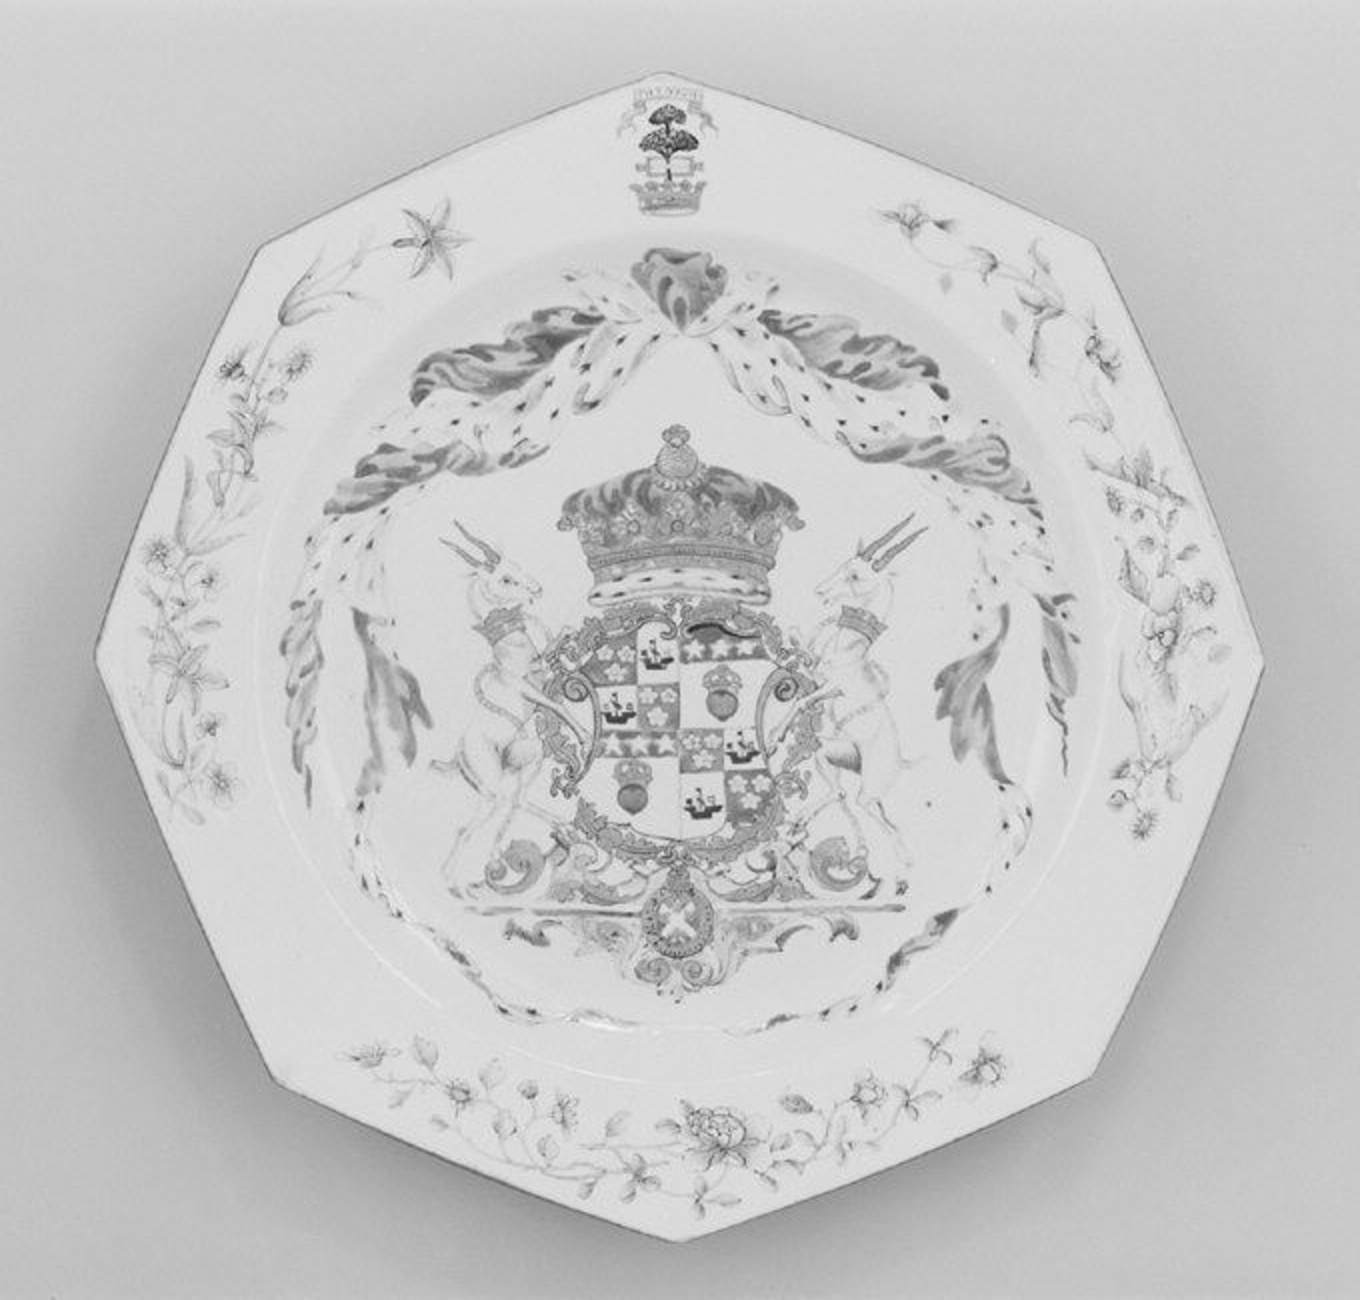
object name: dish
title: Dish (part of a service)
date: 1737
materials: hard paste porcelain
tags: animals,flowers,coat of arms